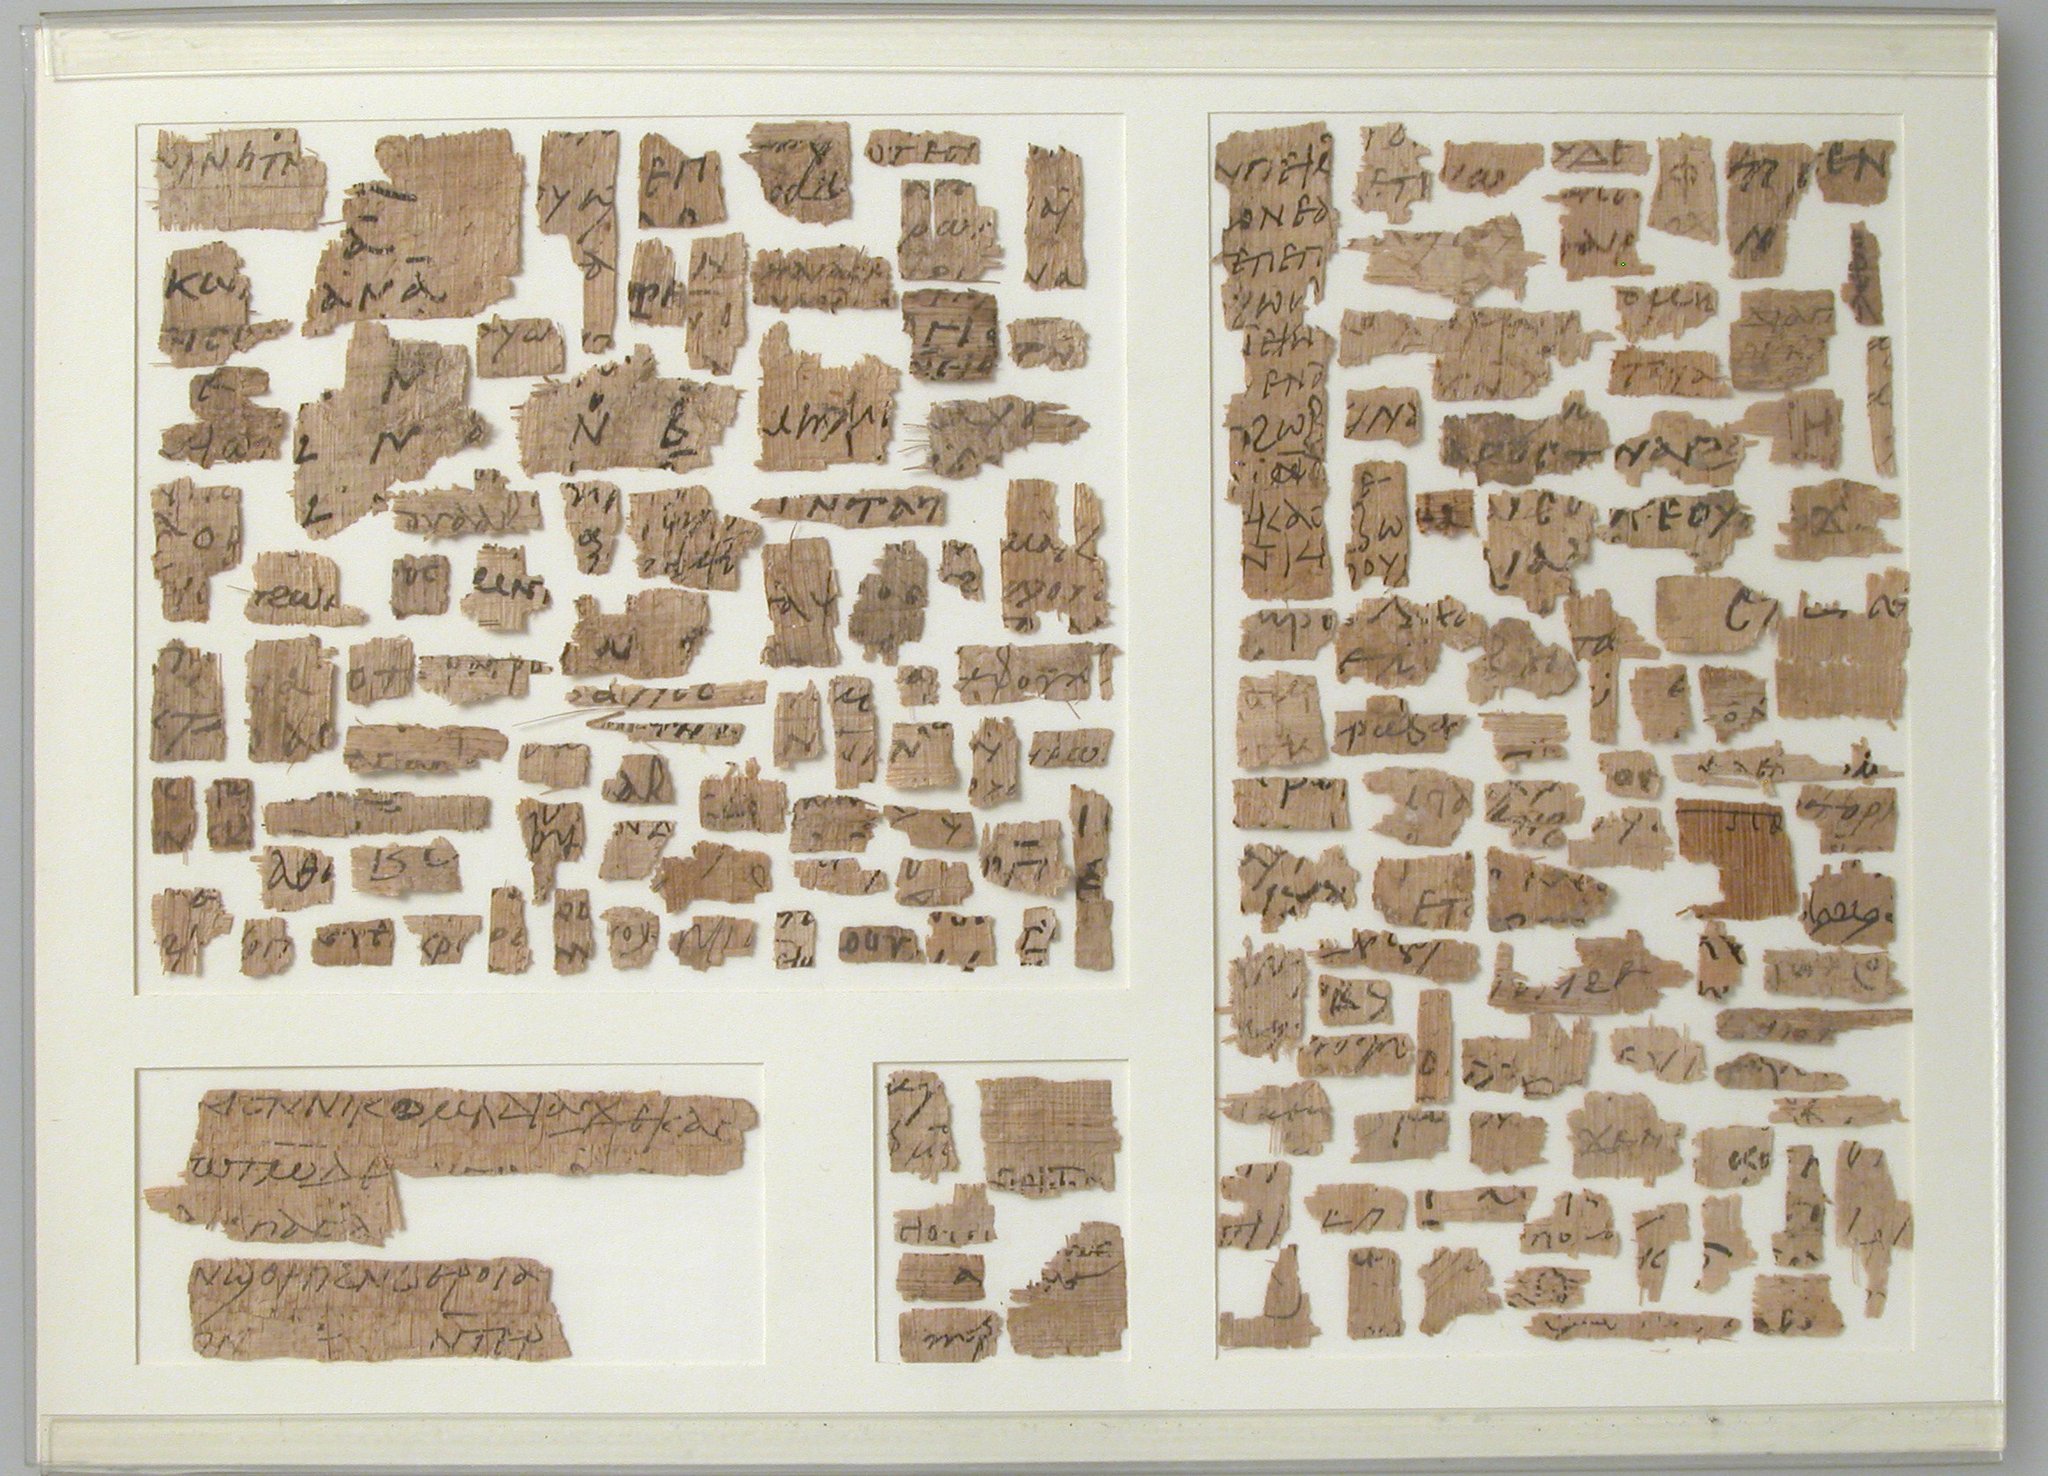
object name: fragment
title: Papyri Fragments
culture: coptic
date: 601-700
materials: ink, papyrus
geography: egypt